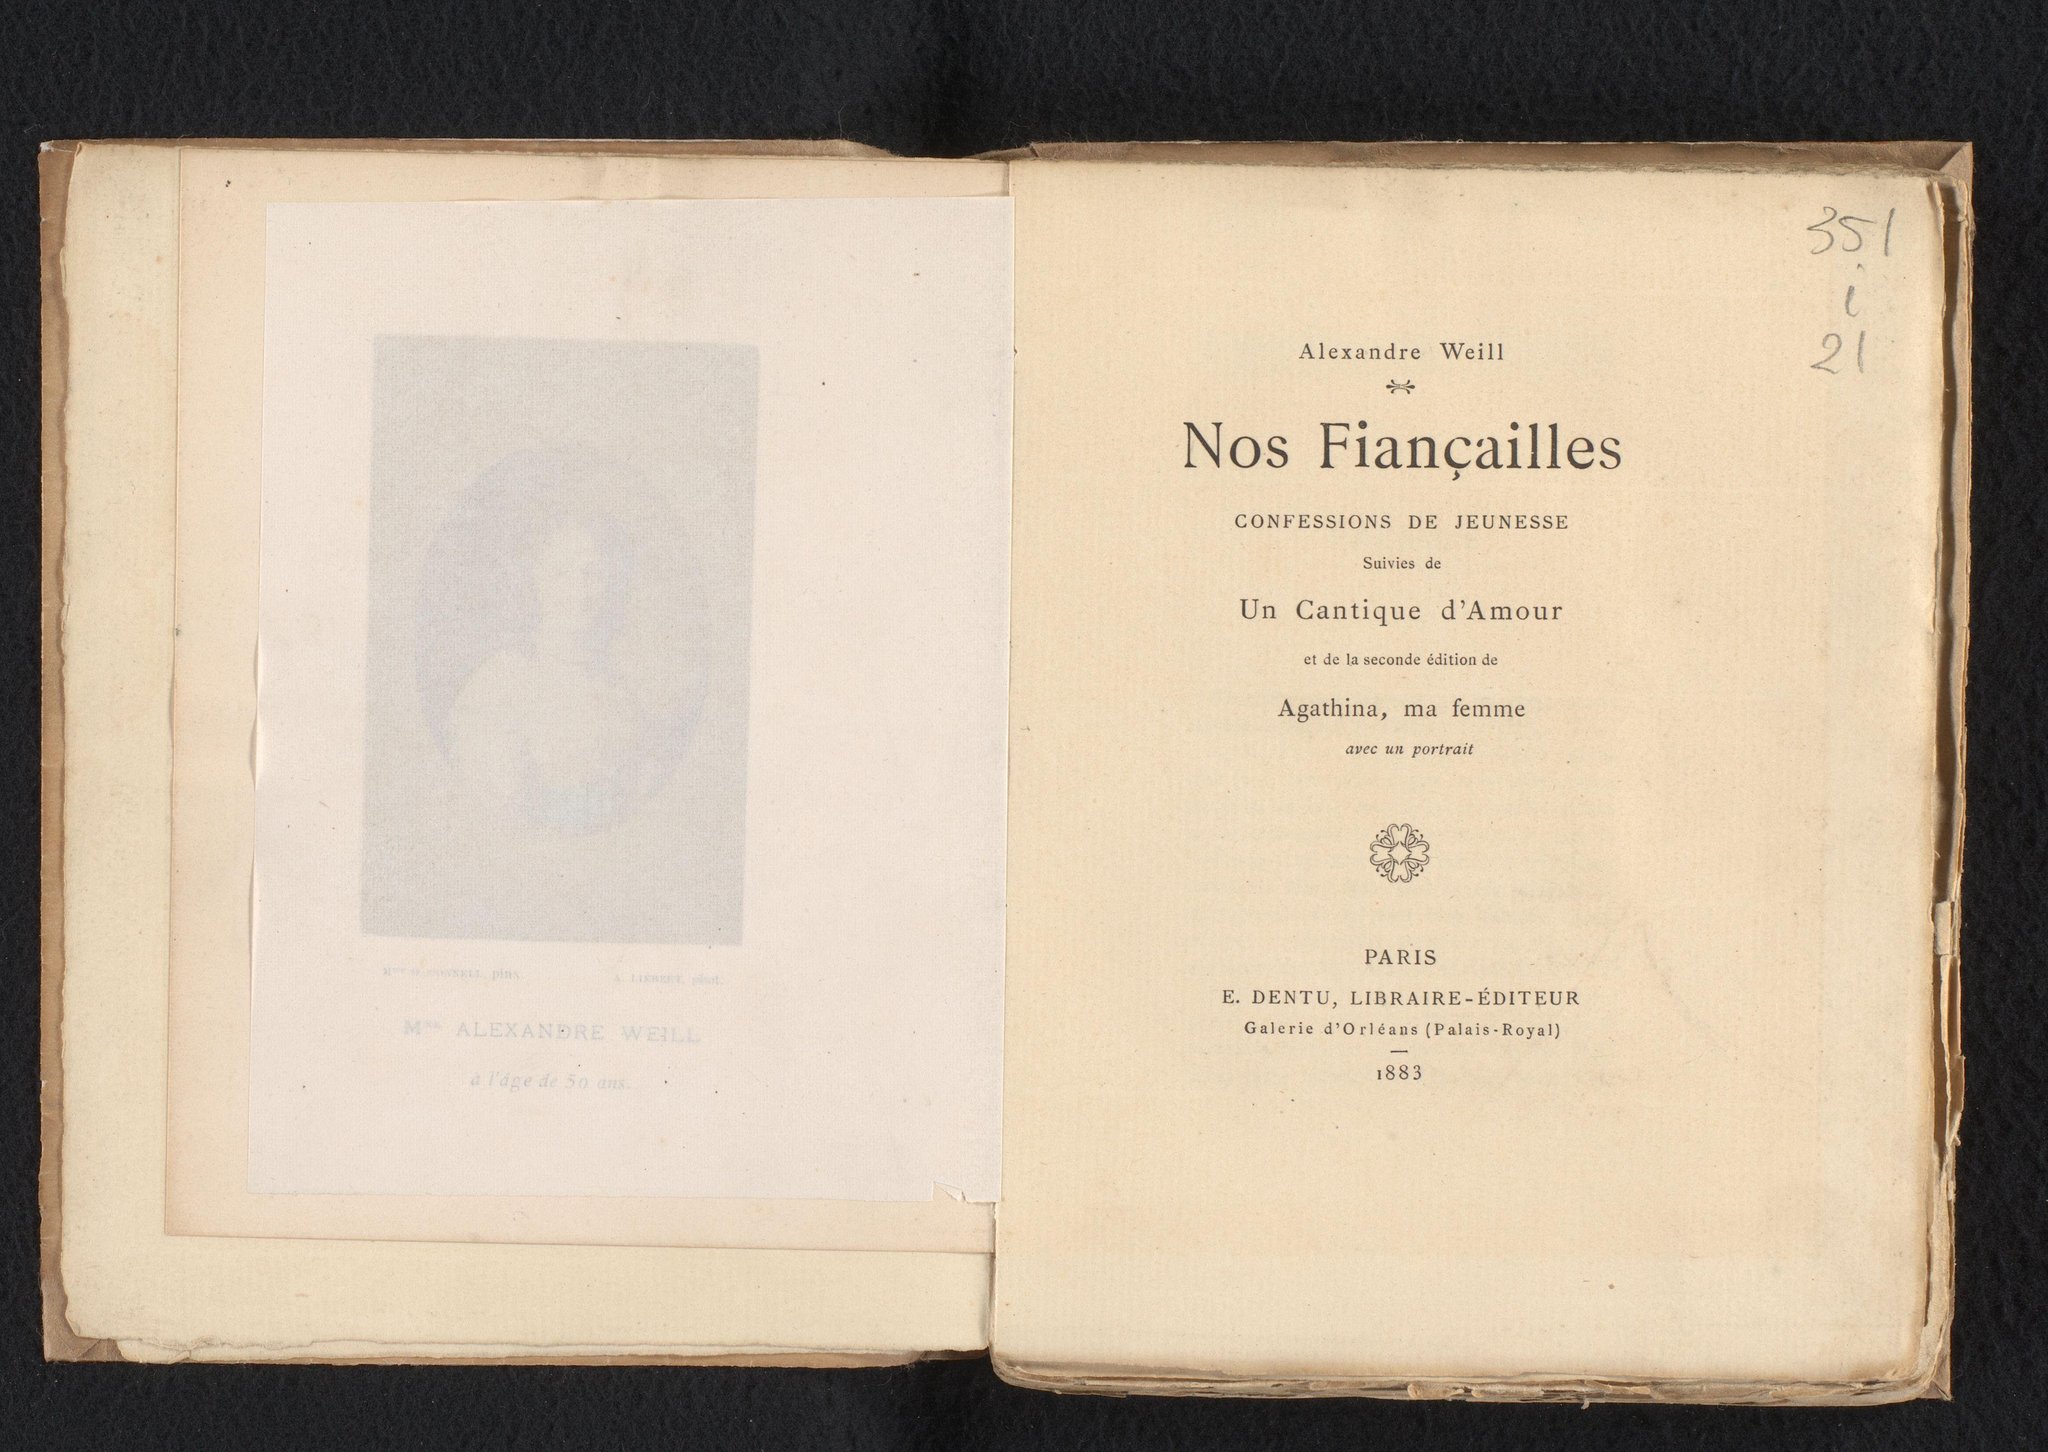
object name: book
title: Nos fiançailles : confessions de jeunesse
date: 1883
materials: paper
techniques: albumen print, letterpress printing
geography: paris